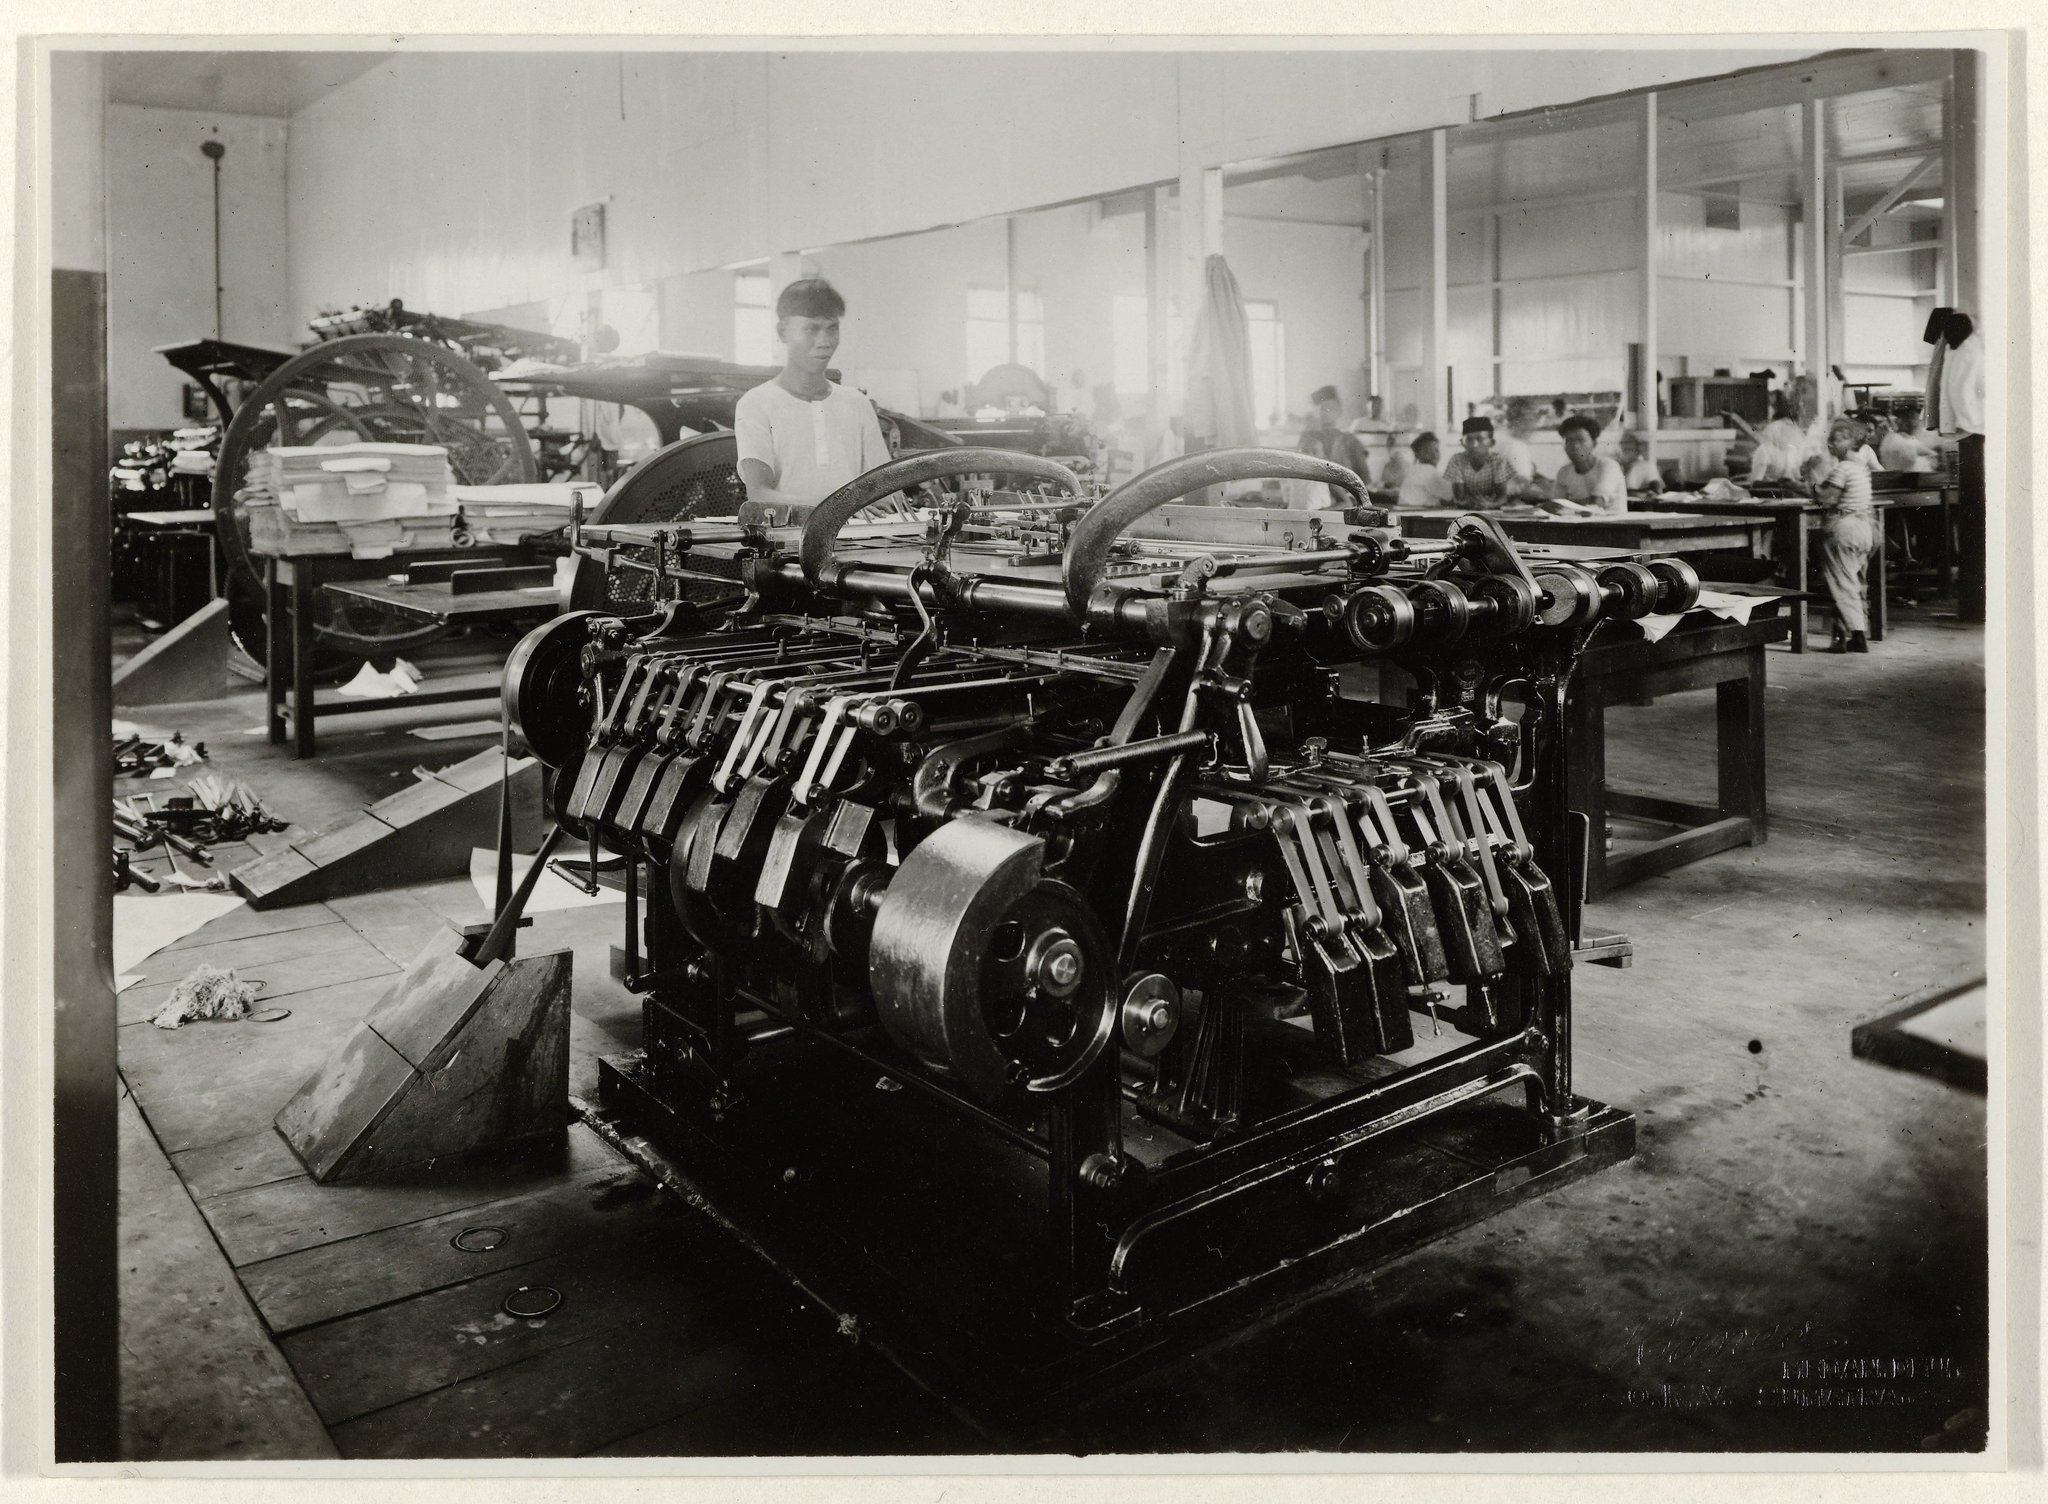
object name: photograph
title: Vouwmachine in de drukkerij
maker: t. kaneo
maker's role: fotograaf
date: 1921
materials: photographic support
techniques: gelatin silver print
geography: medan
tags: dutch east indies, the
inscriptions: inscription: ‘Vouwmachine’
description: Javaanse werknemer bij een vouwmachine in de drukkerij van de Deli Courant te Medan. Onderdeel van een groep van 18 foto's uit 1921 binnen de groep van 49 losse zwart-wit foto's van verschillend formaat over de uitgeverij en drukkerij van de krant Deli Courant in Medan in de periode 1885-1947.